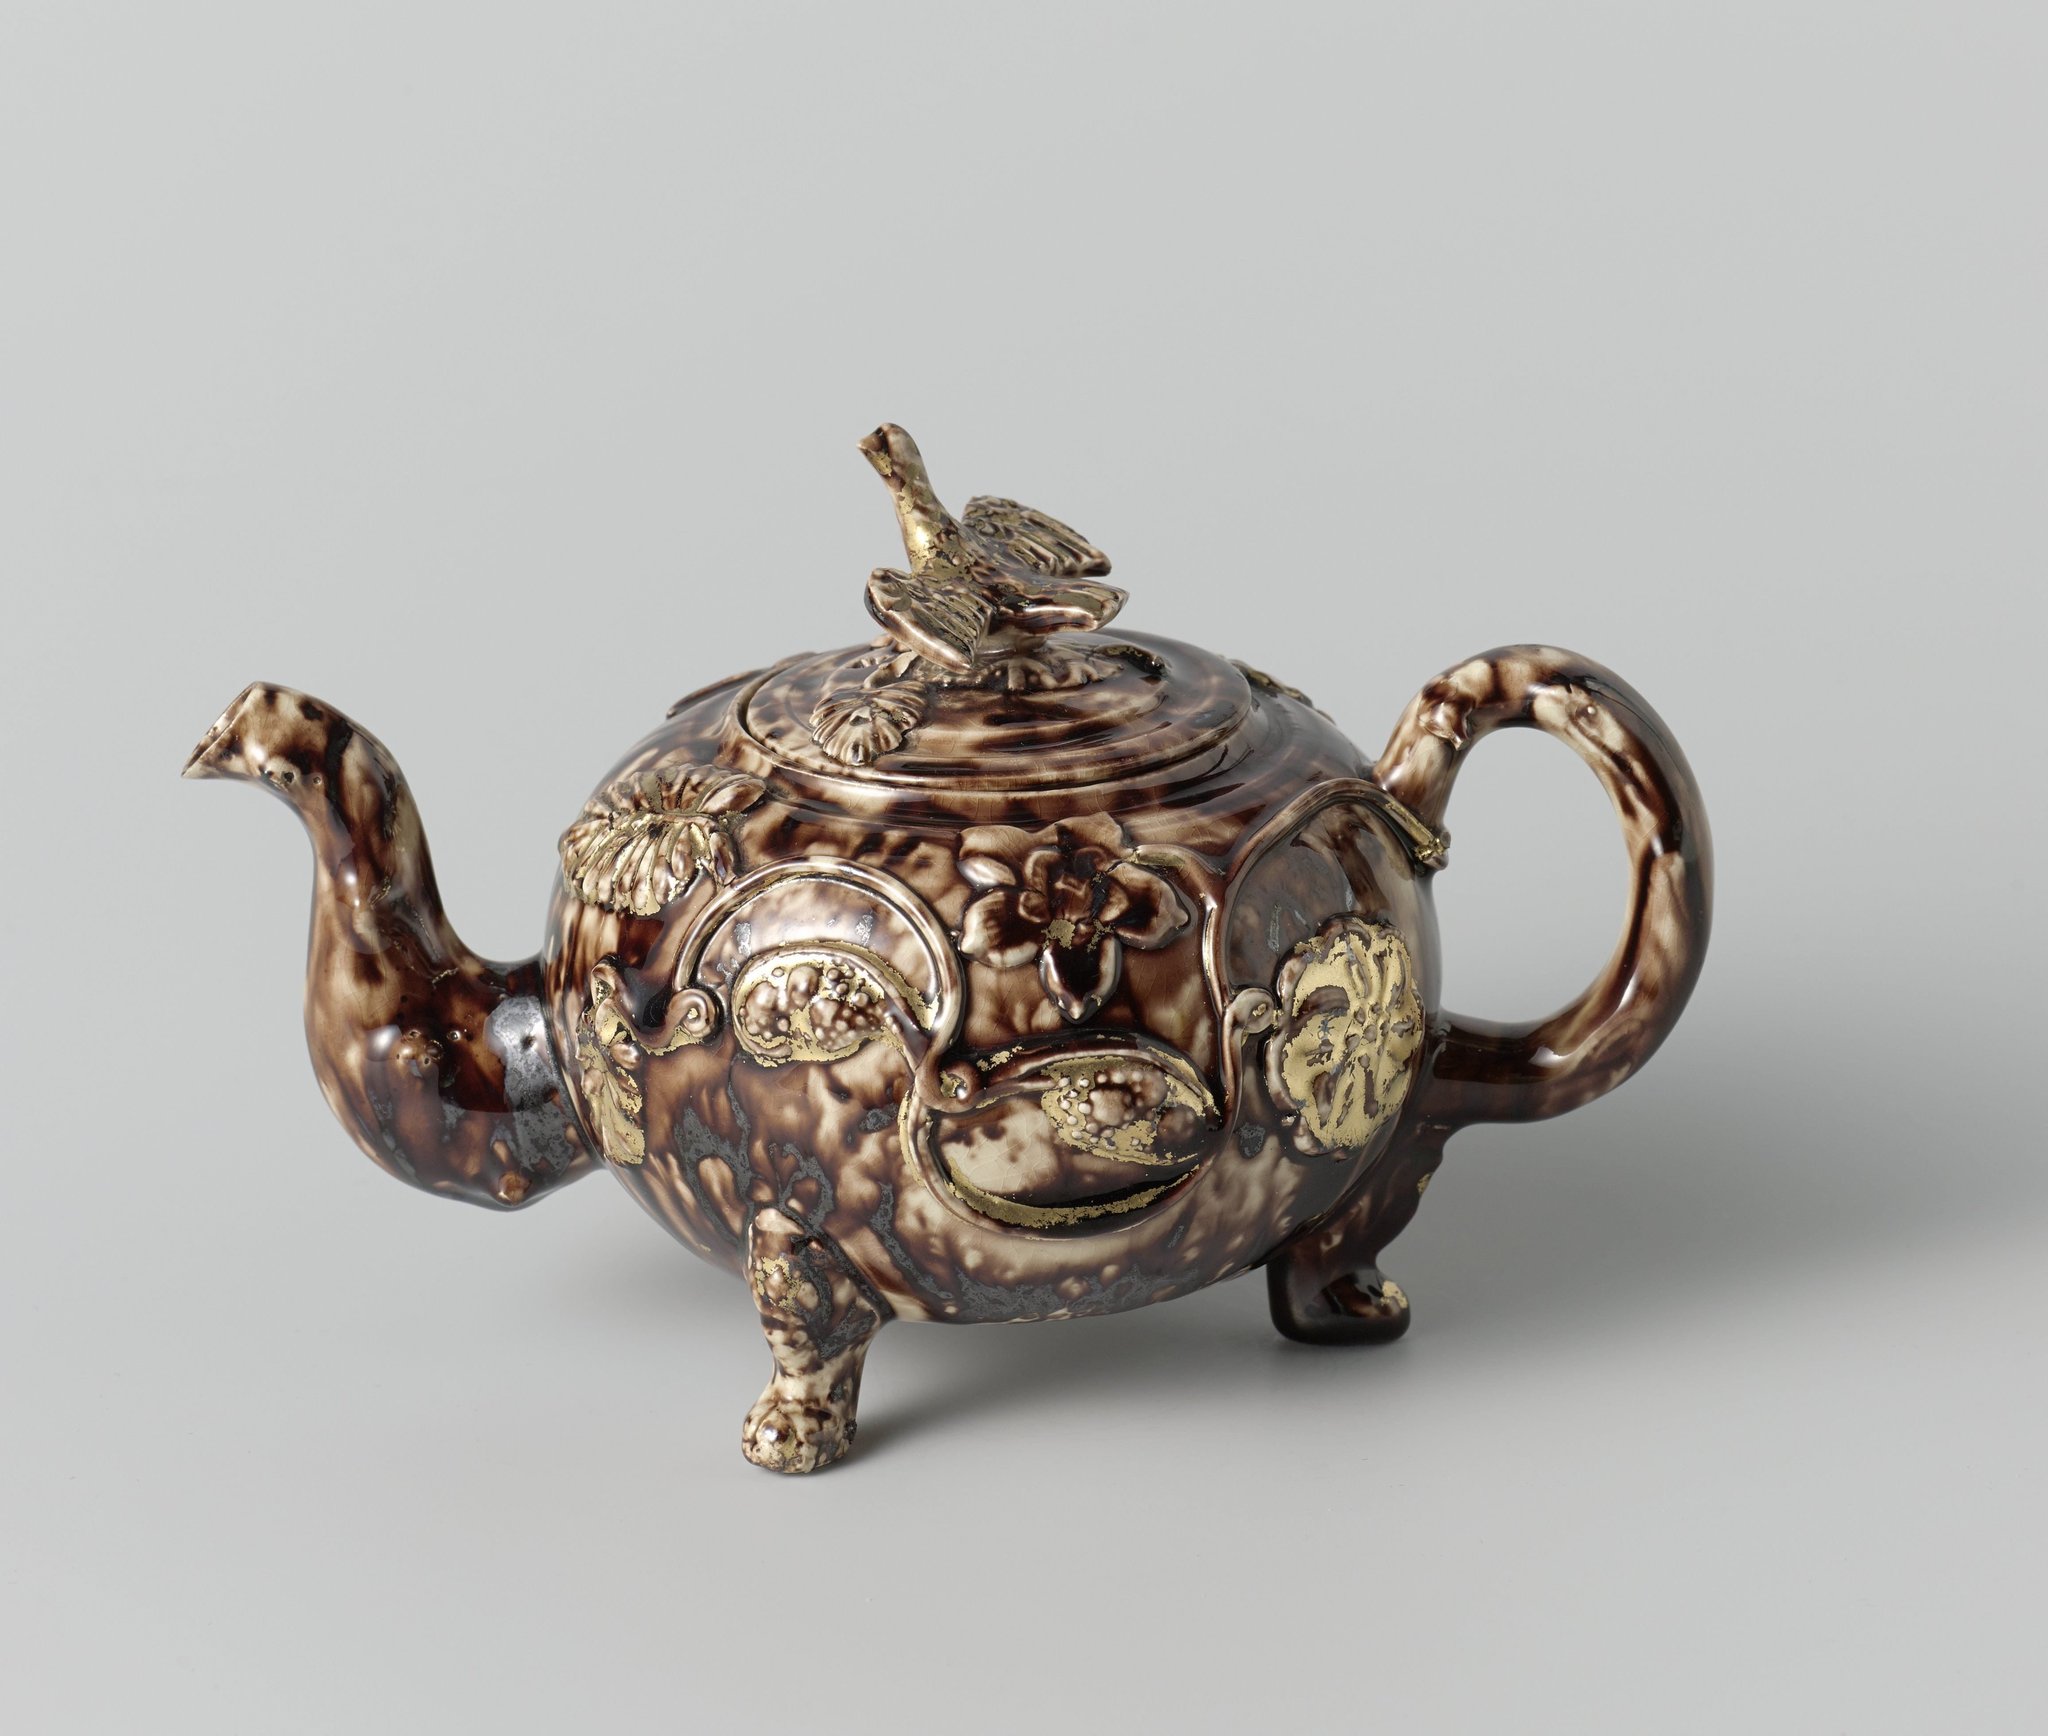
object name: teapot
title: Theepot met deksel van hardgebakken aardewerk; Staffordshire.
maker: Anonymous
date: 1750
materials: earthenware, glaze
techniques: gilding, marbling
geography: england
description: Theepot met deksel van hardgebakken aardewerk. De theepot is bedekt met een bruin gemarmerde loodglazuur en versierd in reliëf met deels vergulde wijnranken met bladeren en druiventrossen. Het deksel heeft een vogel als knop. De theepot hoort bij een melkkan (BK-1977-245-B) en een spoelkom (BK-1977-245-C).